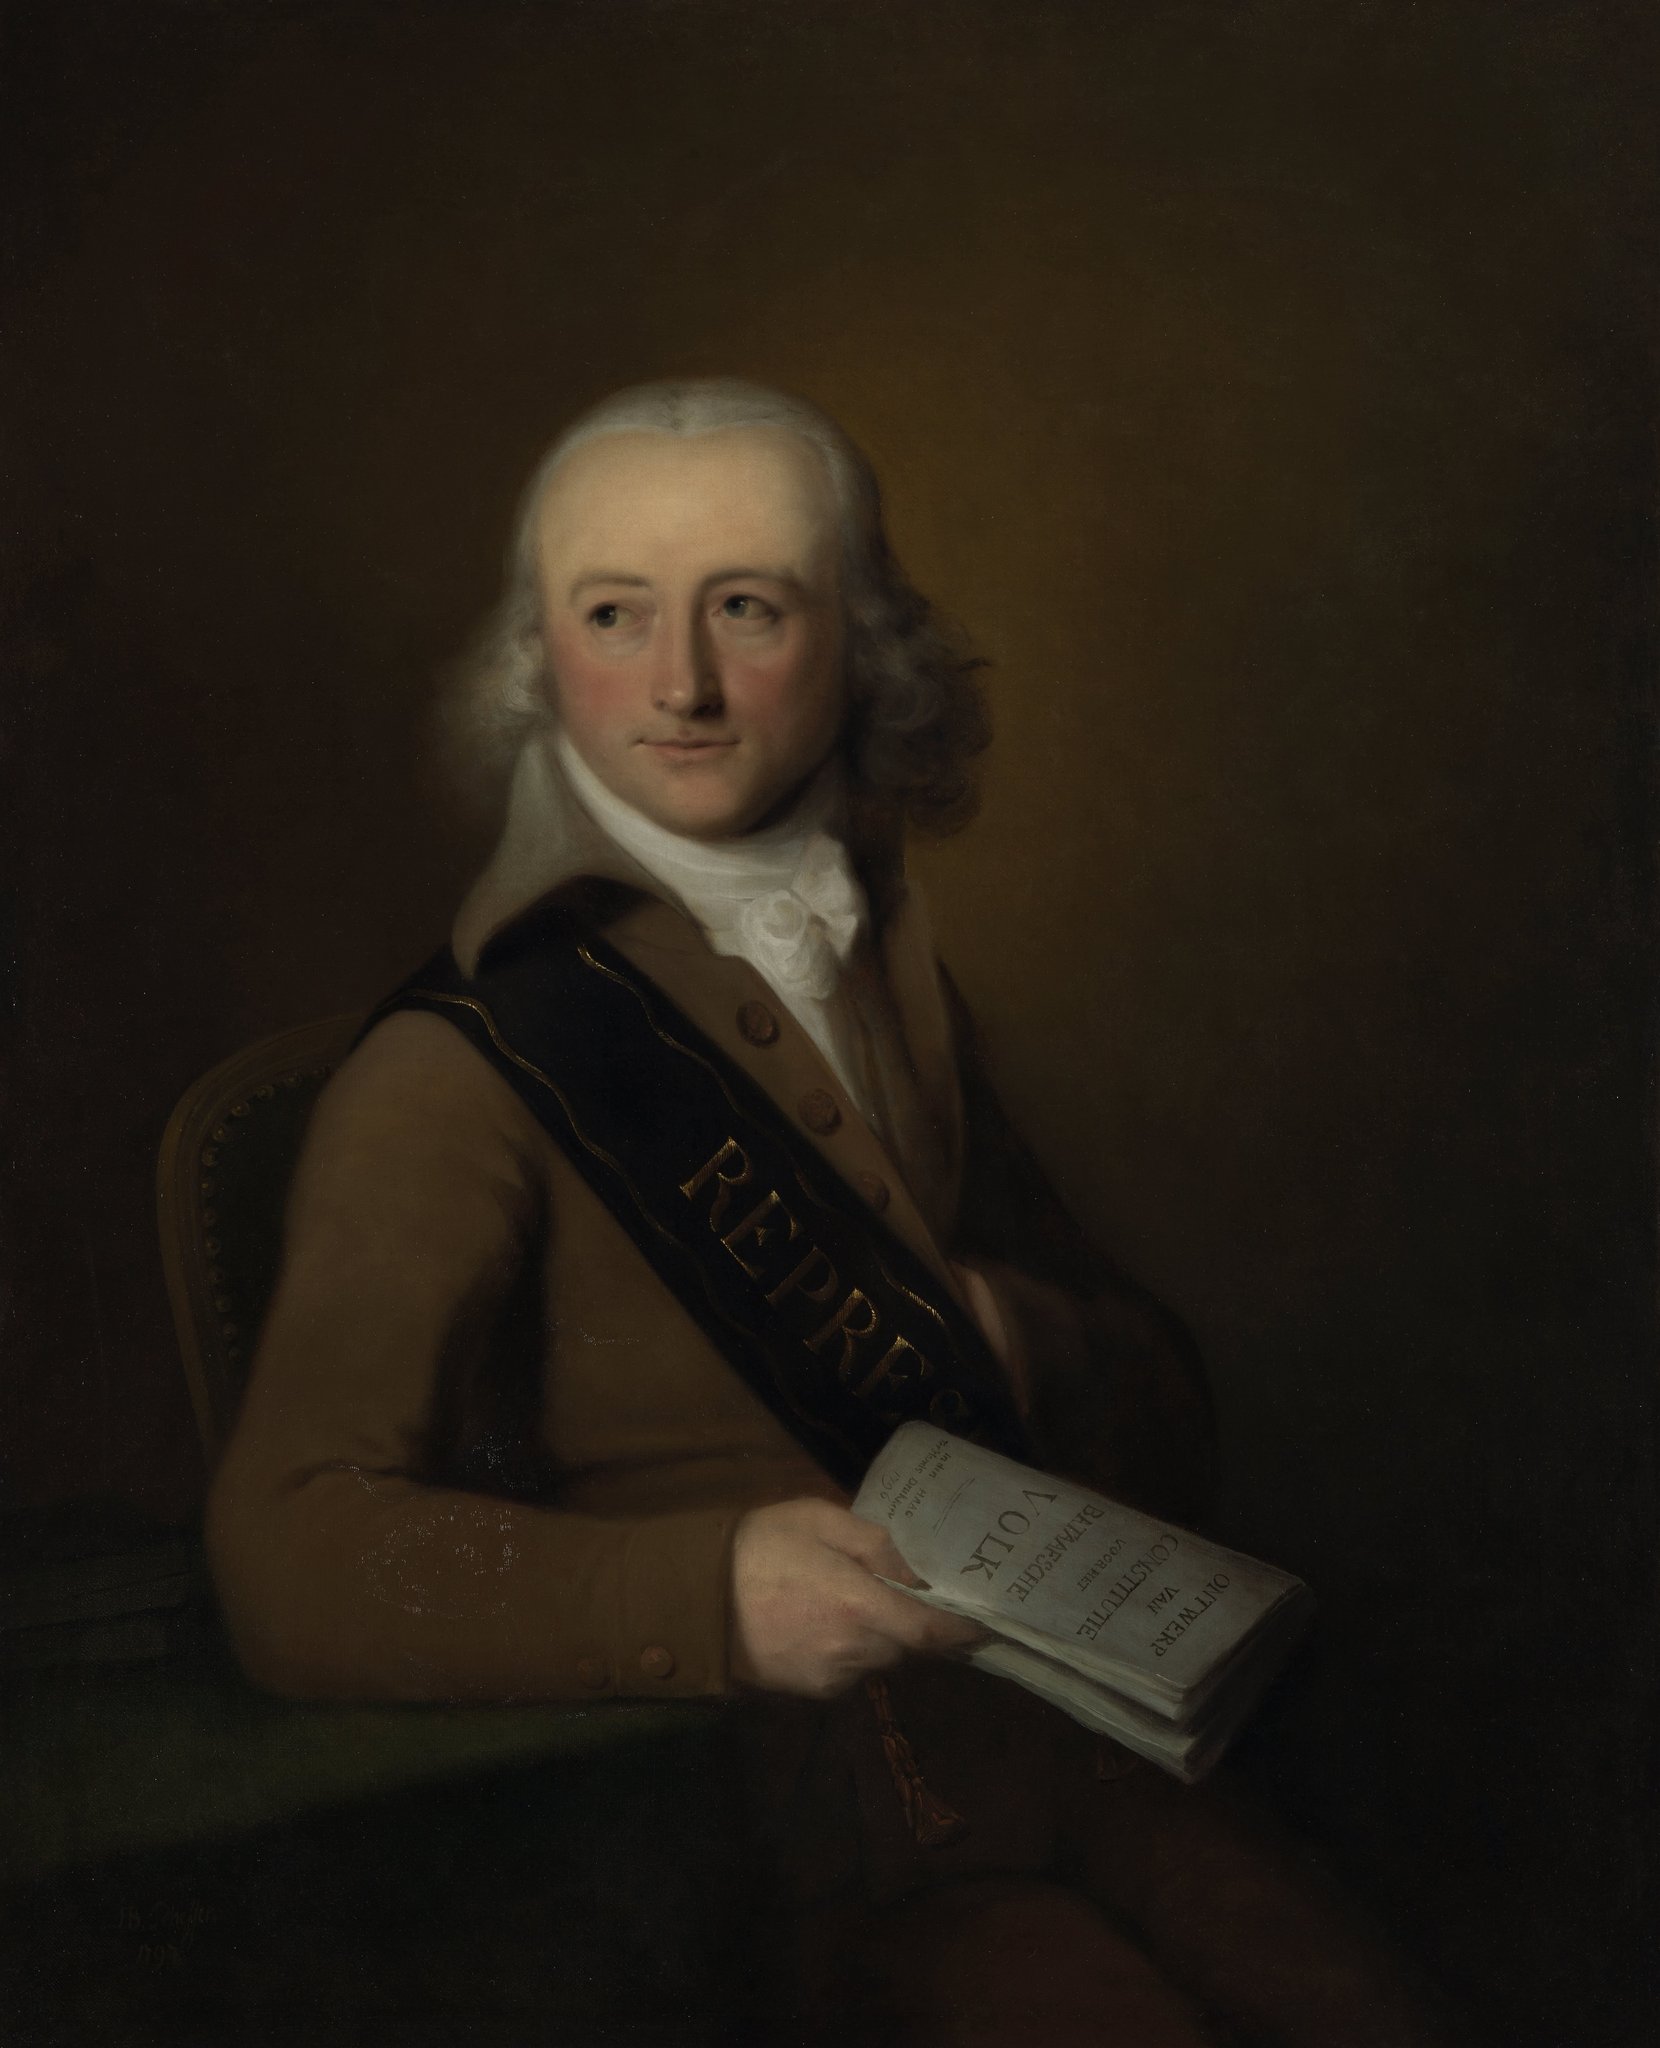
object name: painting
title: Portrait of Leonardus van der Voort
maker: johan bernard scheffer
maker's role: draughtsman, painter, print maker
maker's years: 1765-1809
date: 1799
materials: oil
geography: netherlands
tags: historical persons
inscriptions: inscription: ‘Med:Doct: Leonardus van der Voort geb. 5 Februari 1762 te Boxtel overl. 8 October 1809 aldaar.’, inscription: ‘o.a. Concept Grondwet’, inscription: ‘REPRESENTANT’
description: Leonardus van der Voort was one of Holland’s delegates to the National Assembly. He holds the draft of the Constitution of the Batavian Republic of 1796, a forerunner of the first Constitution of 1798. He wears the sash donned by all of the people’s delegates. As far as is known, this is the only painted portrait of a member of the National Assembly.